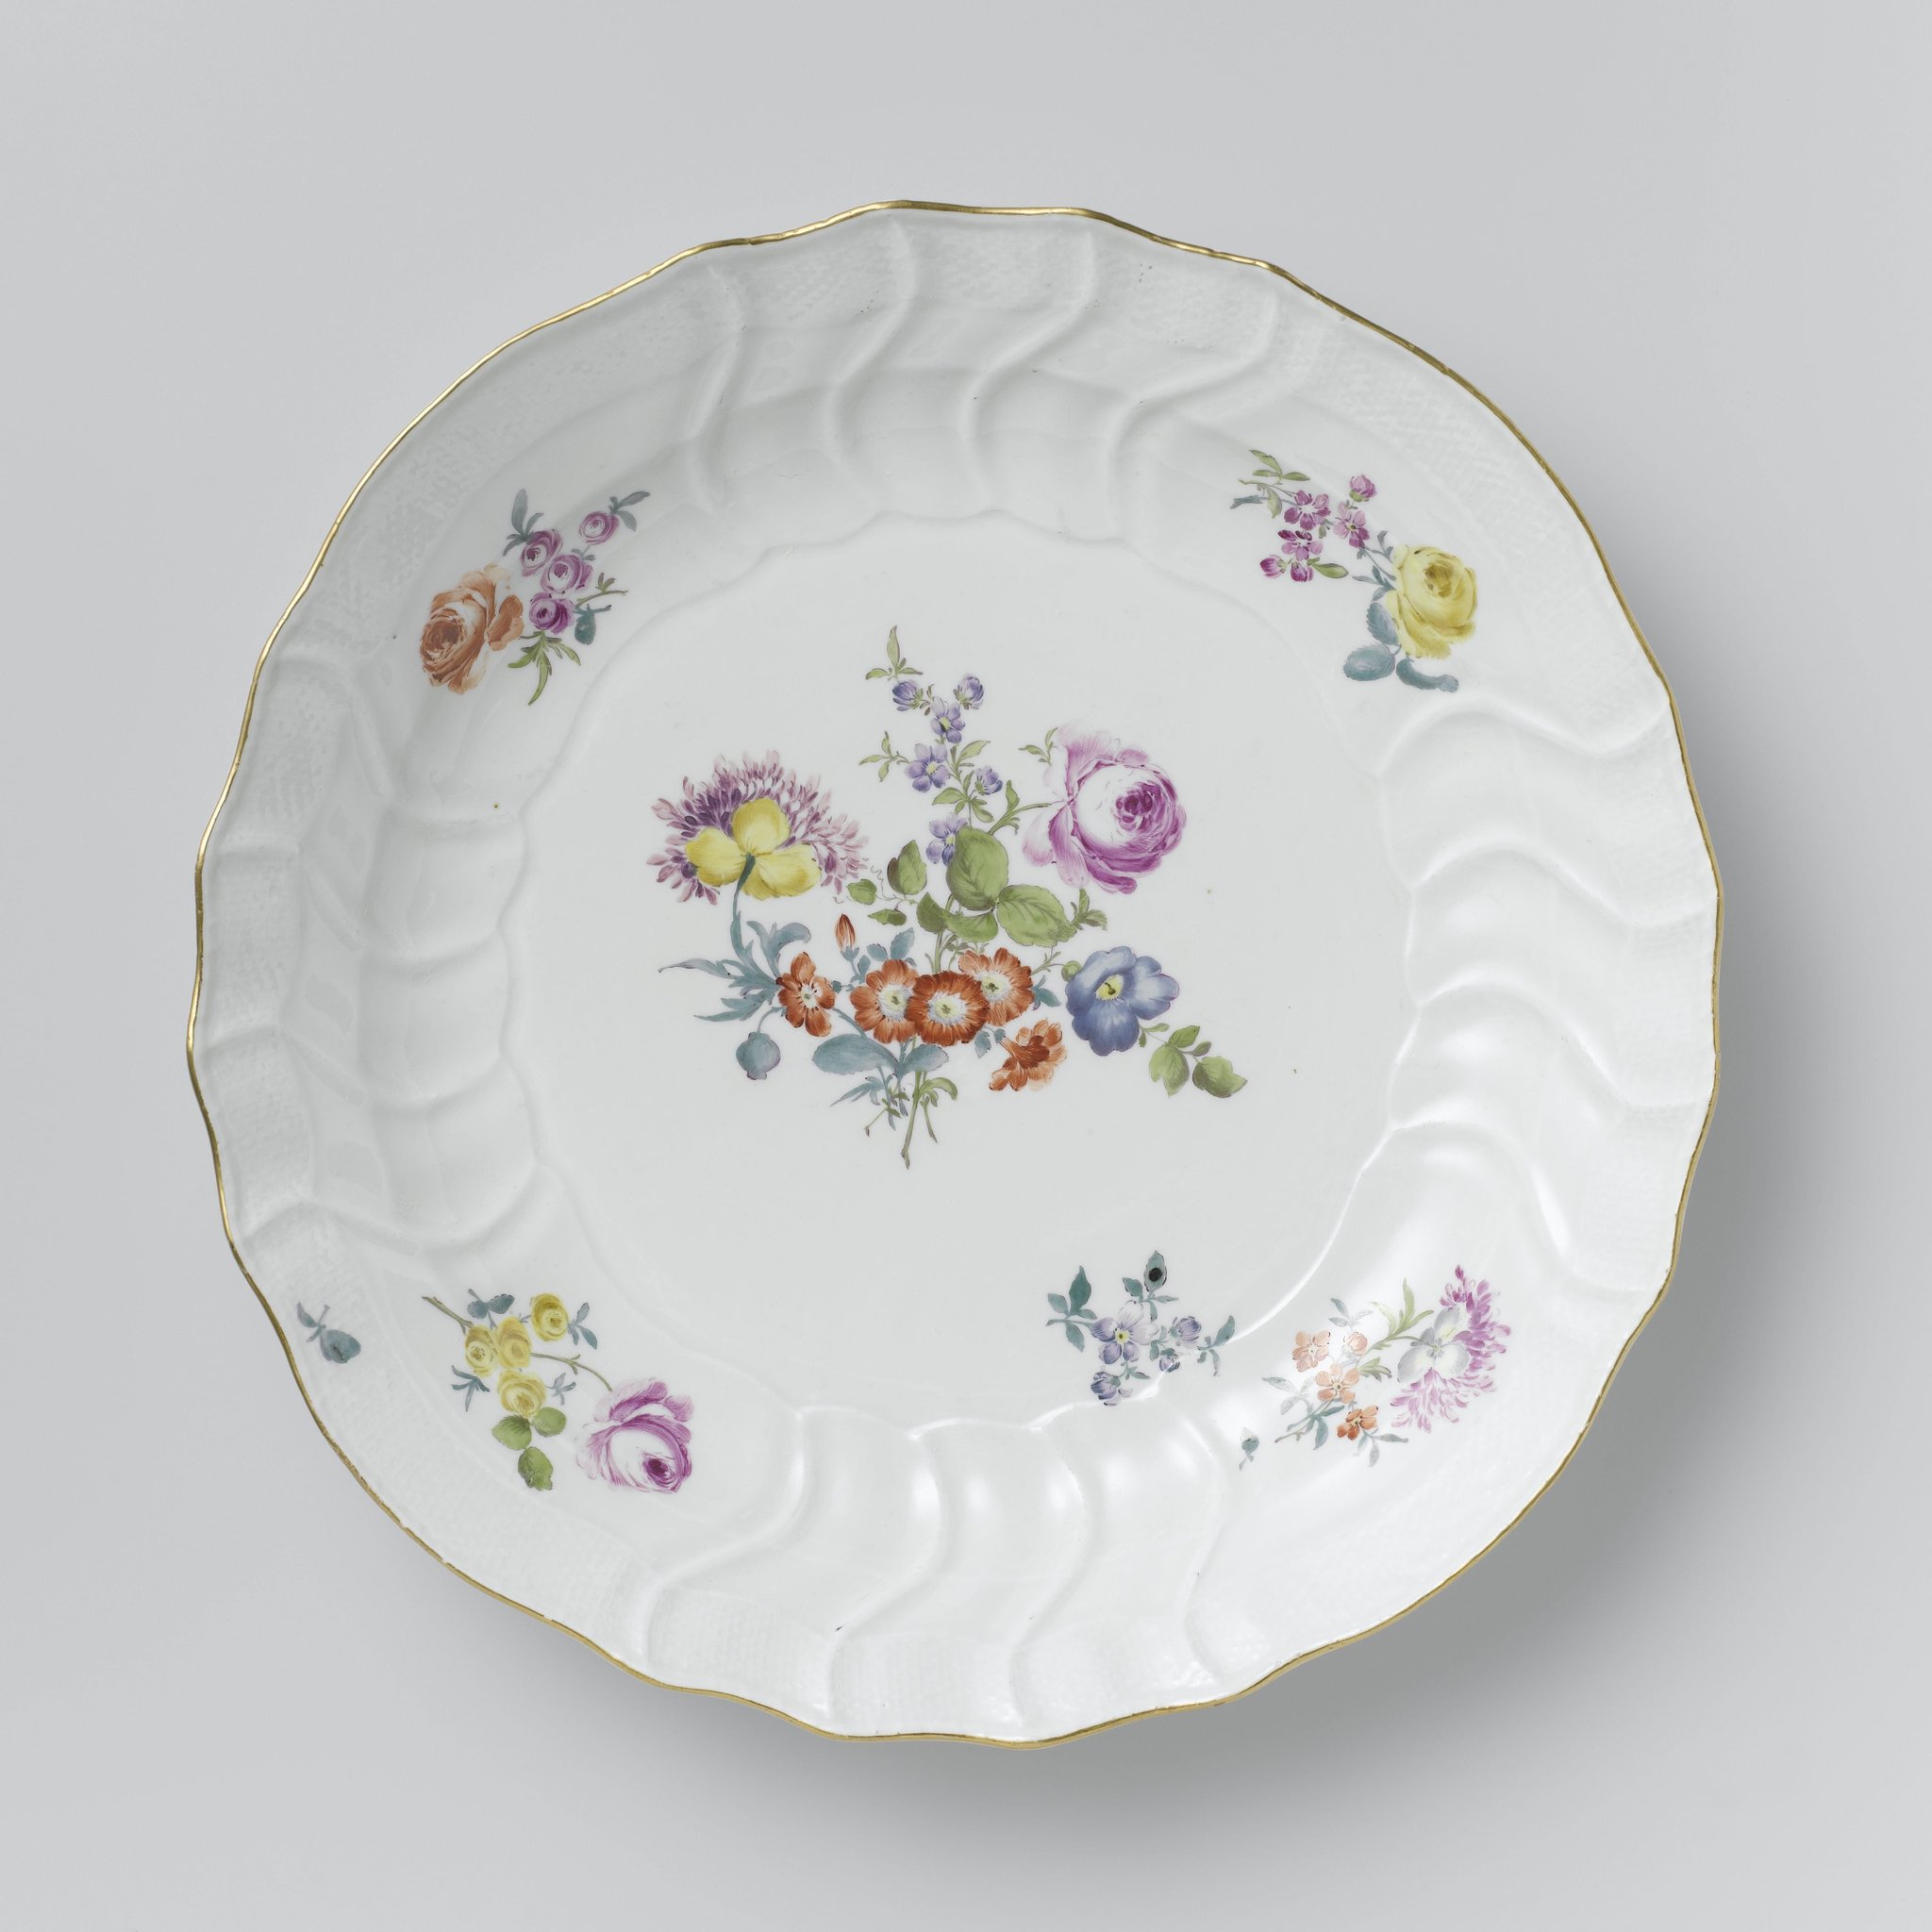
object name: platter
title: Schotel, veelkleurig beschilderd met Deutsche Blumen, insekten en vruchten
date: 1750-1760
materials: porcelain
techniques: painted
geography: meissen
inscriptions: factory mark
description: Ronde schotel van beschilderd porselein. De schotel is beschilderd met Deutsche Blumen, insekten en vruchten. De rand is in reliëf versierd met het Neuozier-patroon. De schotel is gemerkt en hoort bij een servies (BK-17474-1 t/m BK-17474-253).